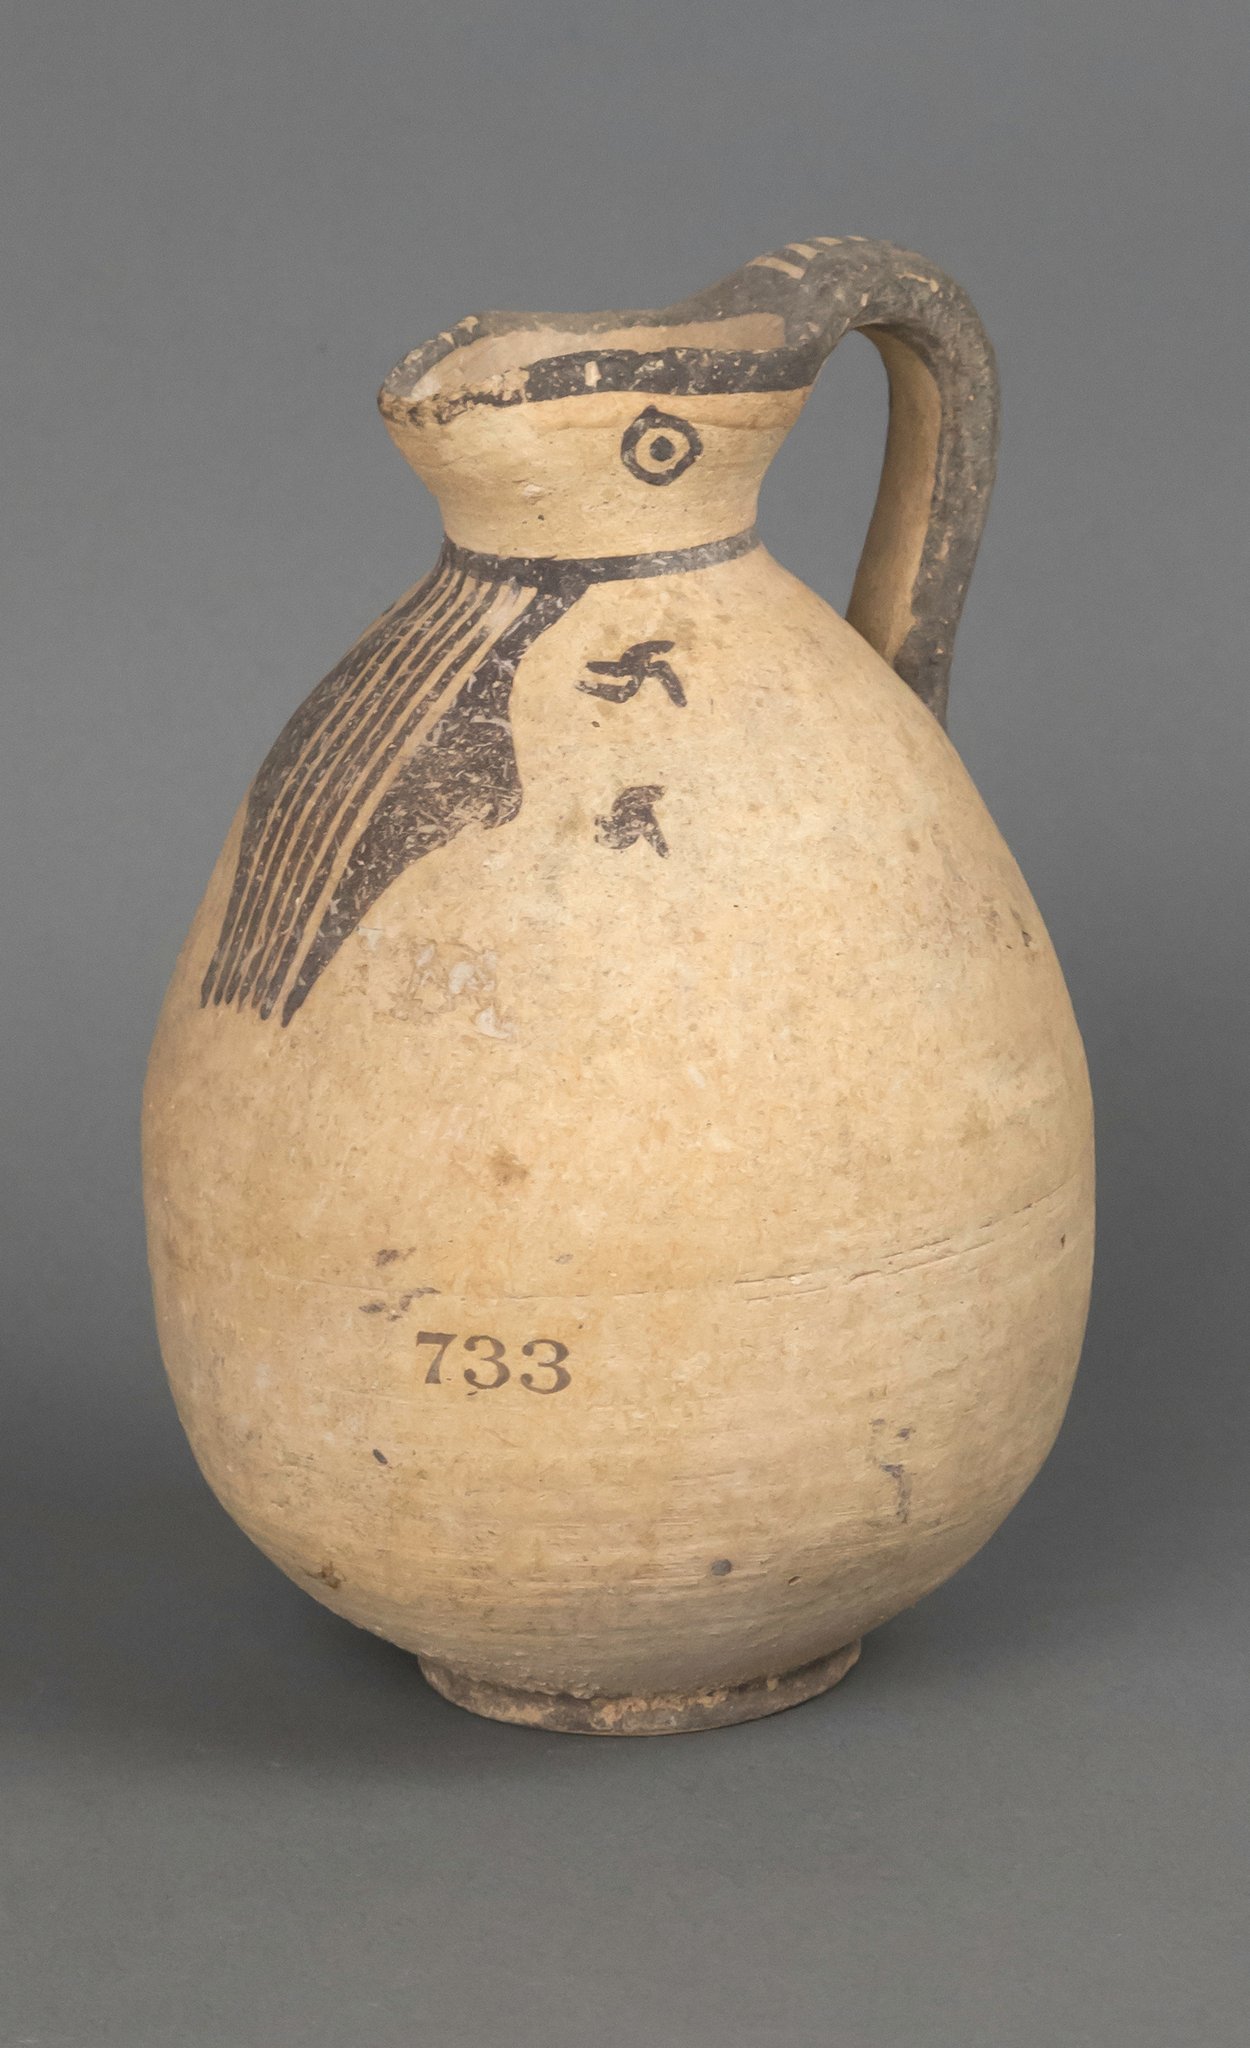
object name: juglet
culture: cypriot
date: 750-600 BCE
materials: terracotta